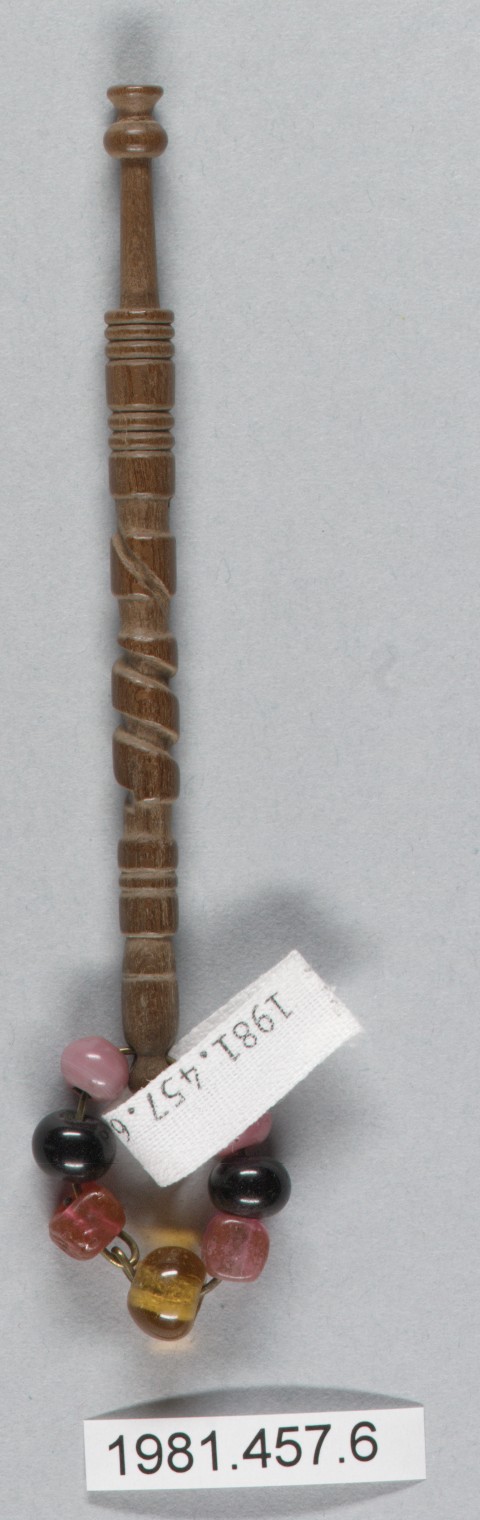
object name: bobbin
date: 1840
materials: wood